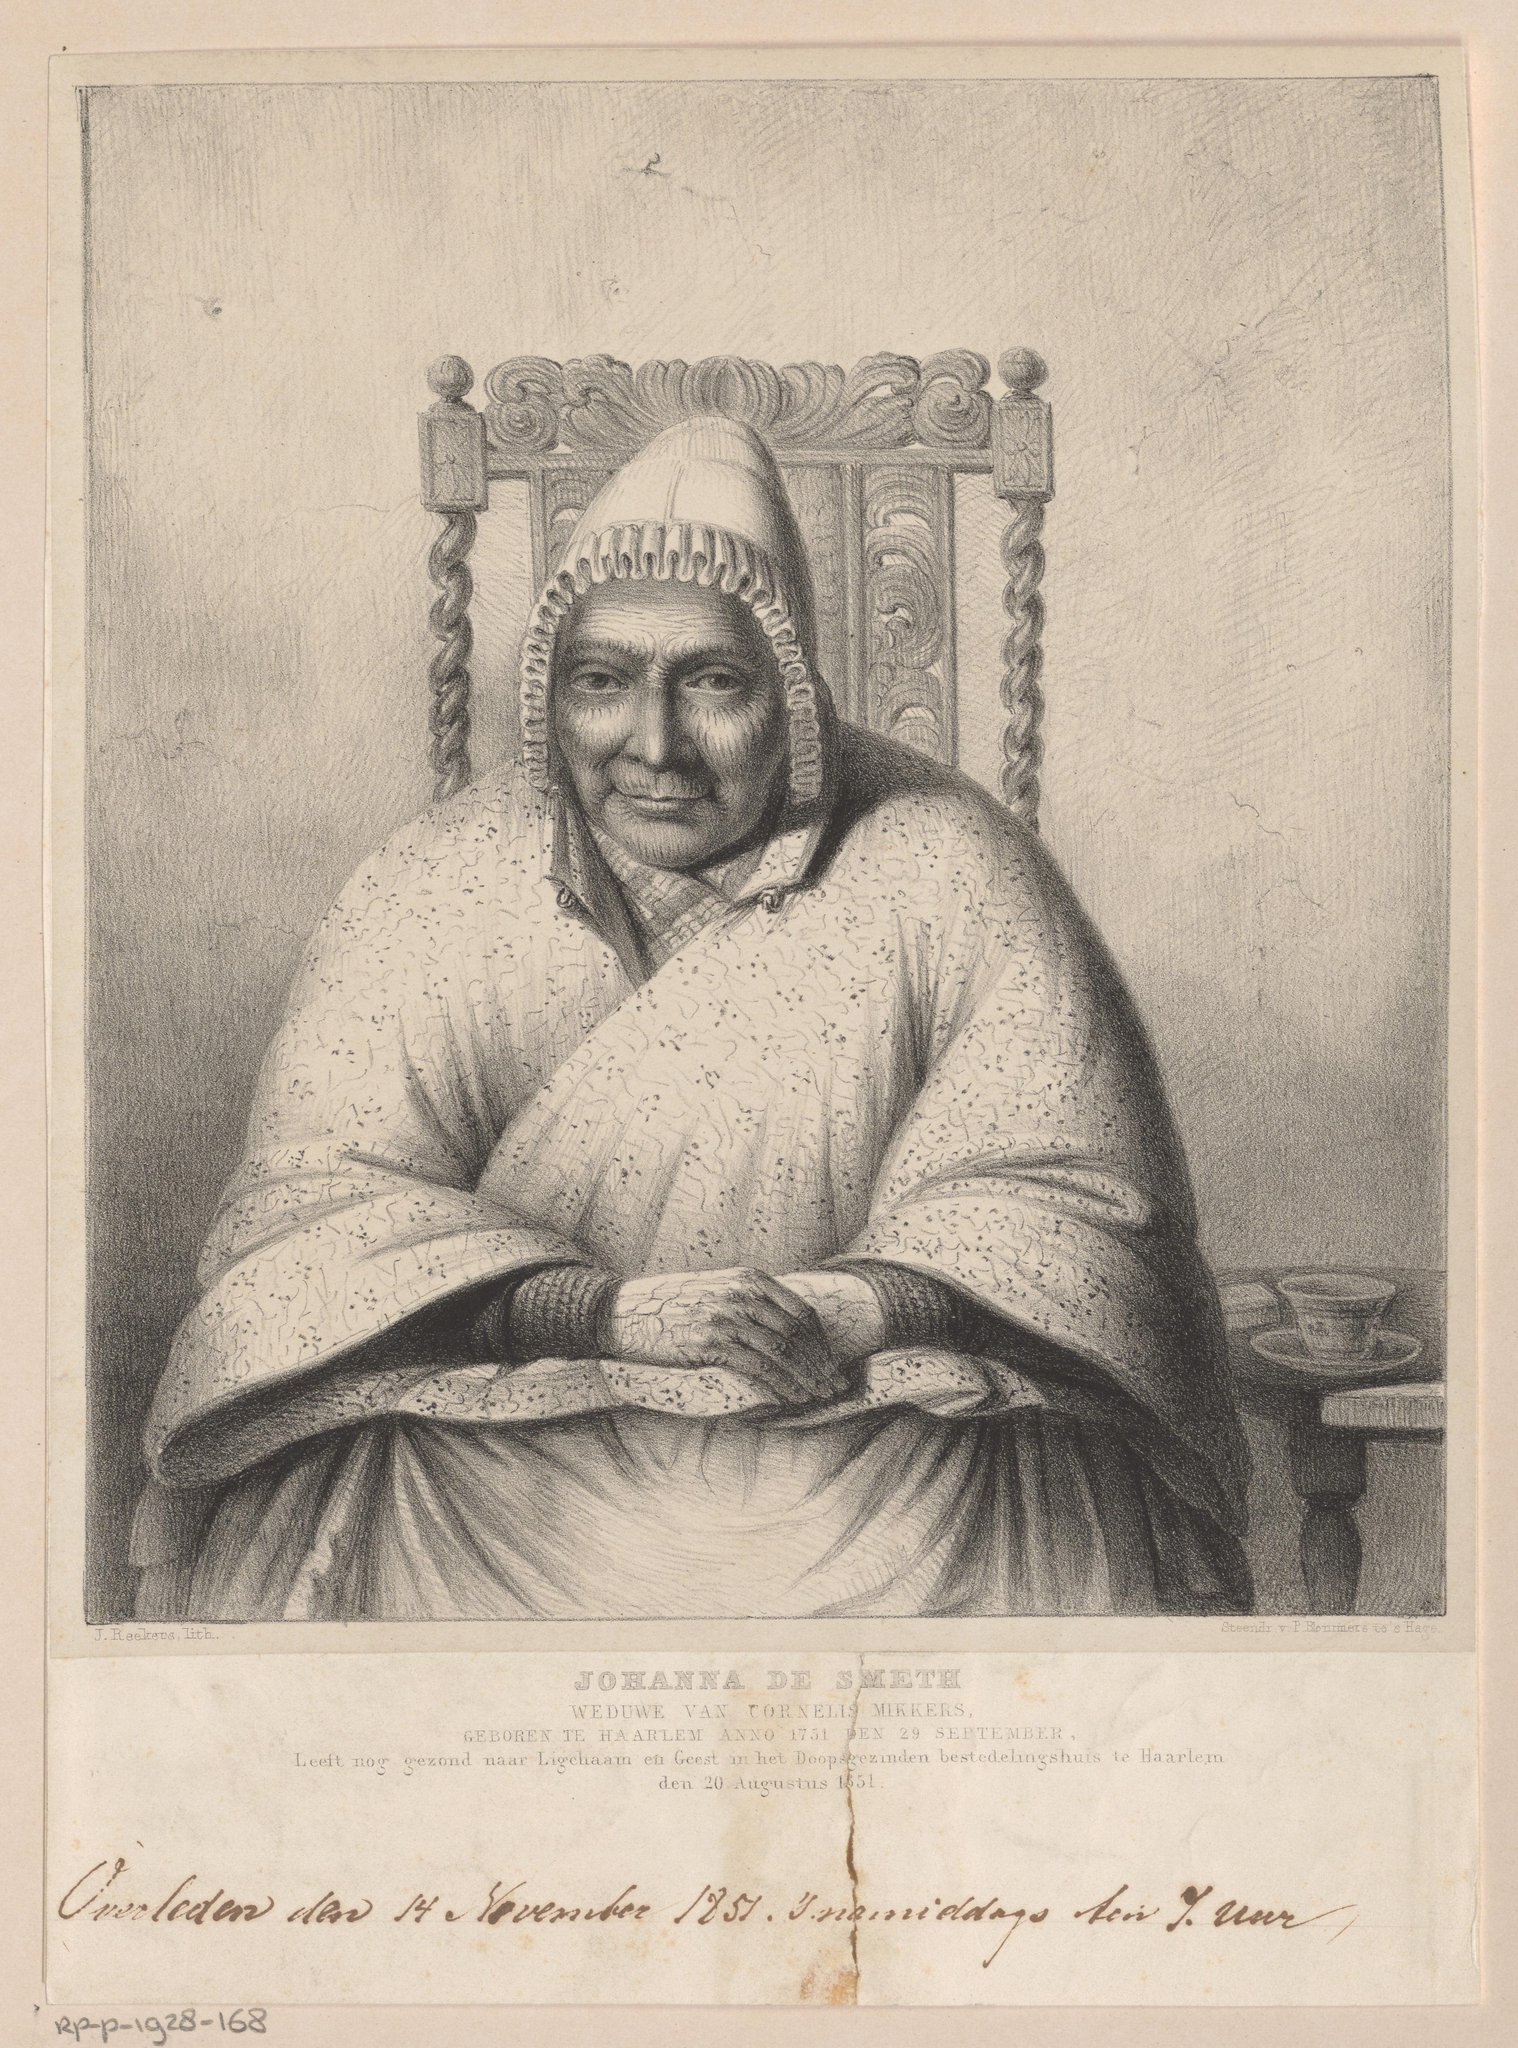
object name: print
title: Portret van Johanna de Smeth op 100-jarige leeftijd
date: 1851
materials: paper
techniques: lithograph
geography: the hague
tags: harlem, haarlem, historical persons - bb - woman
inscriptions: inscription: ‘Overleden den 14 November 1851. 's namiddags ten 7. uur’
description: Met vierregelig onderschrift in het Nederlands.